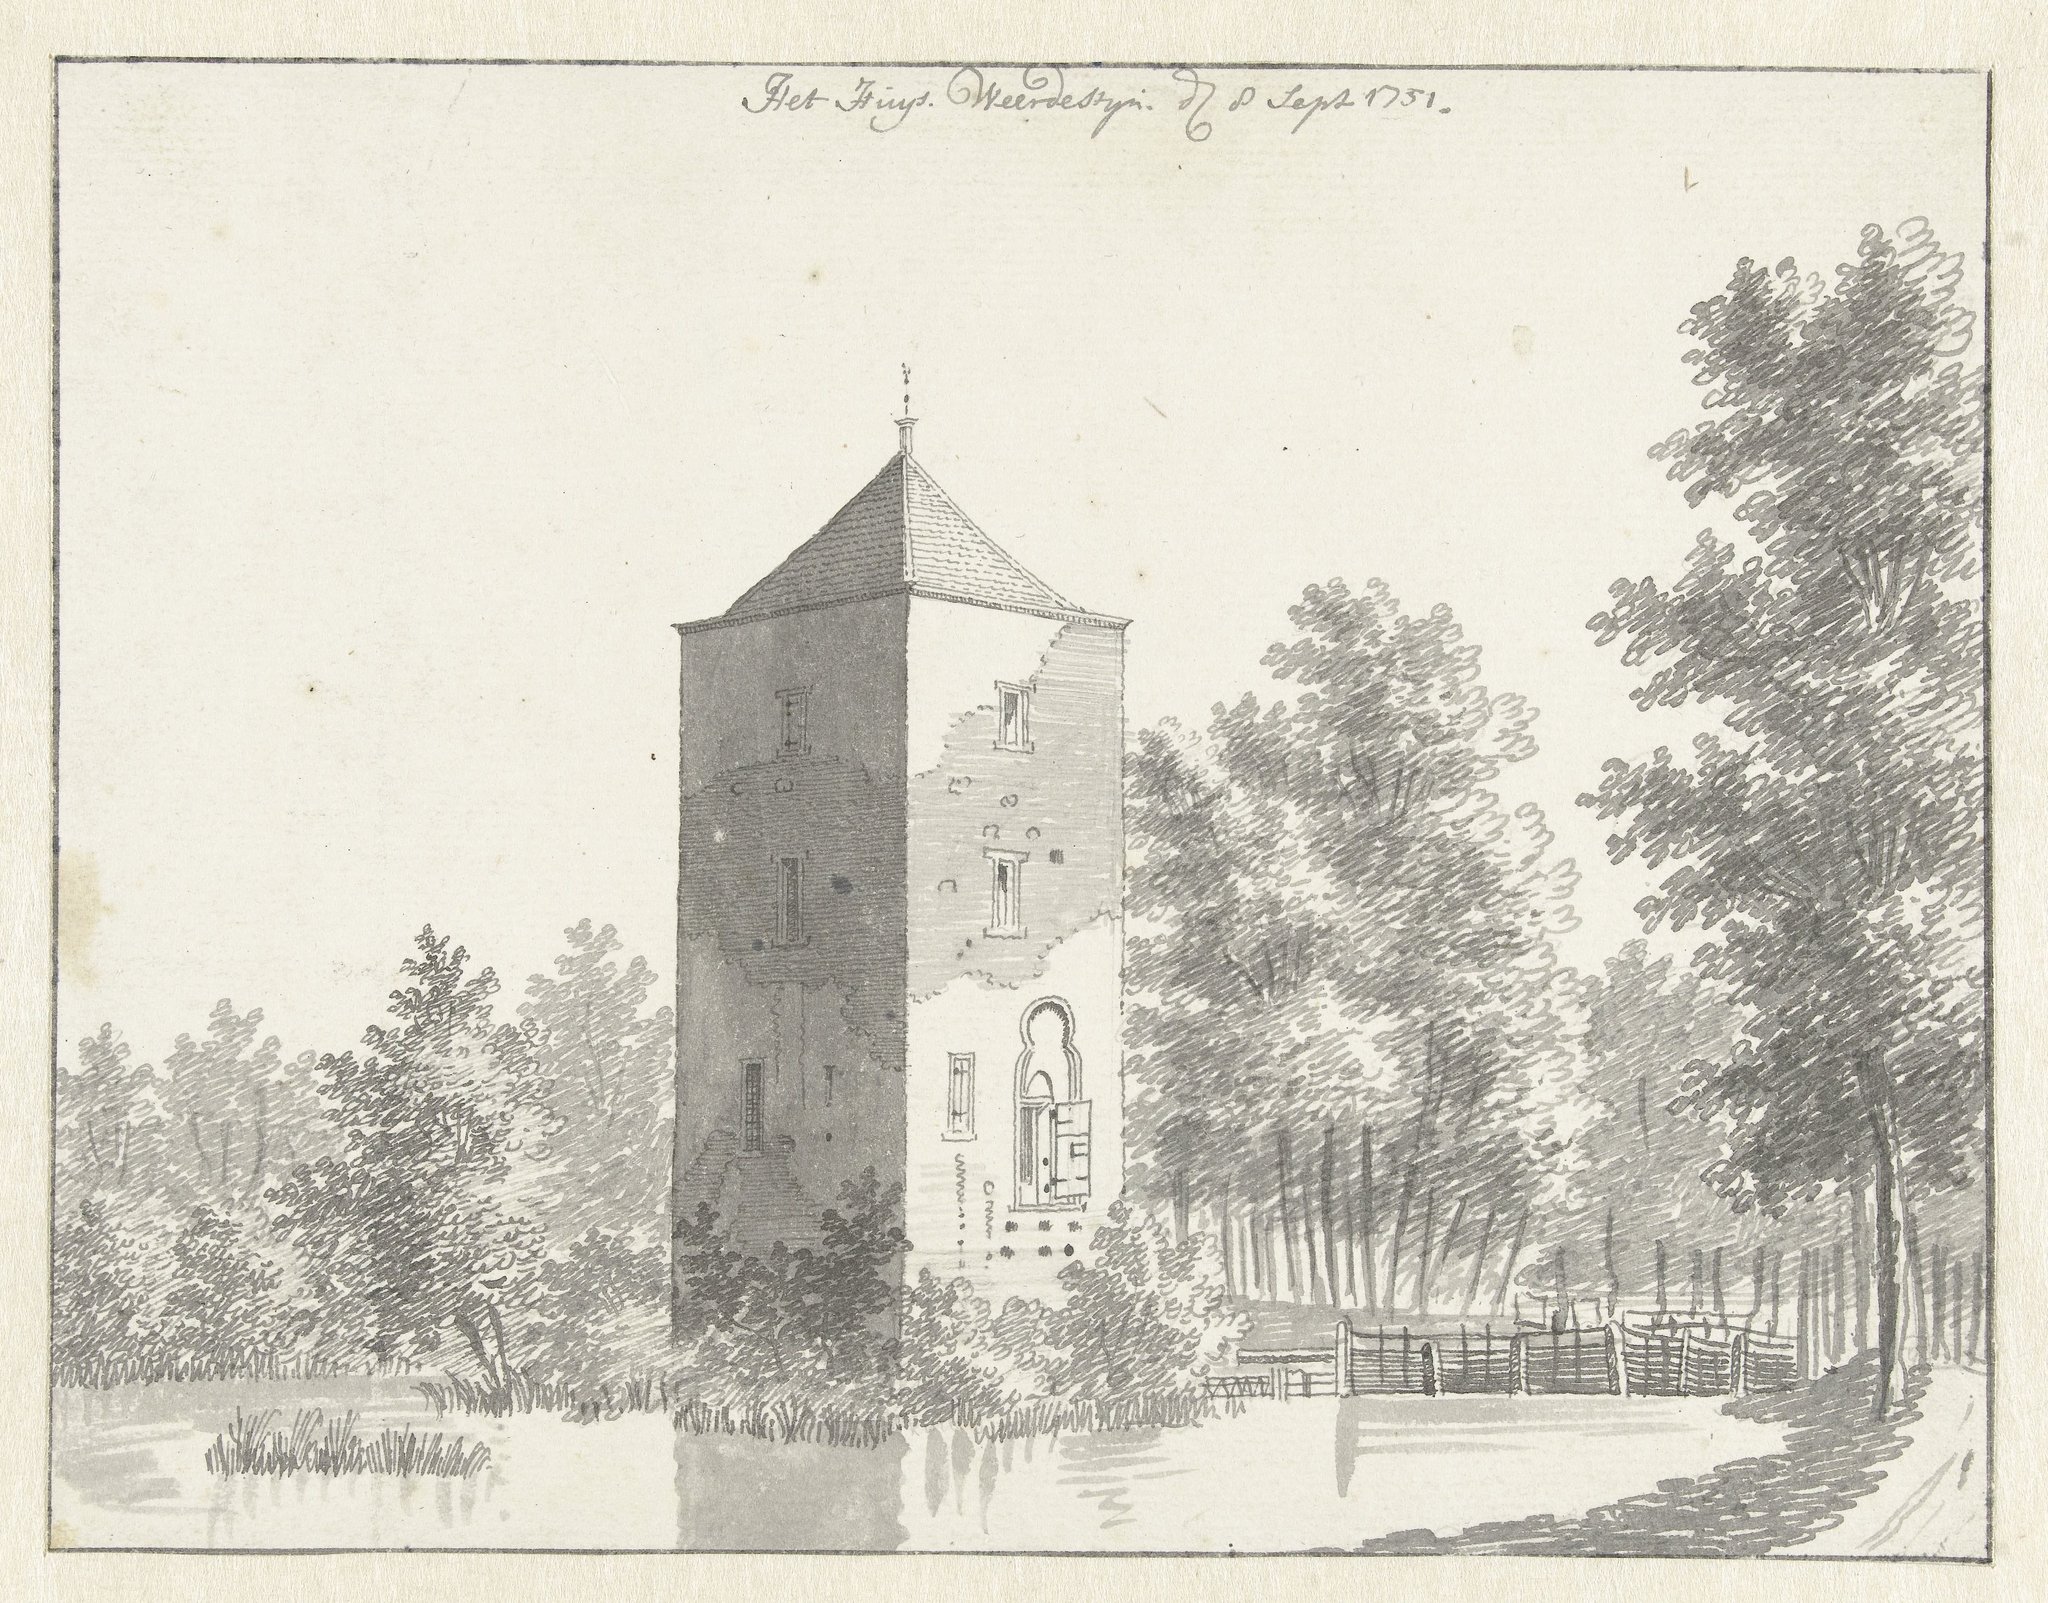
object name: drawing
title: Het Huis Weerdestijn bij Langbroek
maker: paulus van liender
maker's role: draughtsman, print maker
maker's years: 1731-1797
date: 1751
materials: ink, paper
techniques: brush, pen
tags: castle